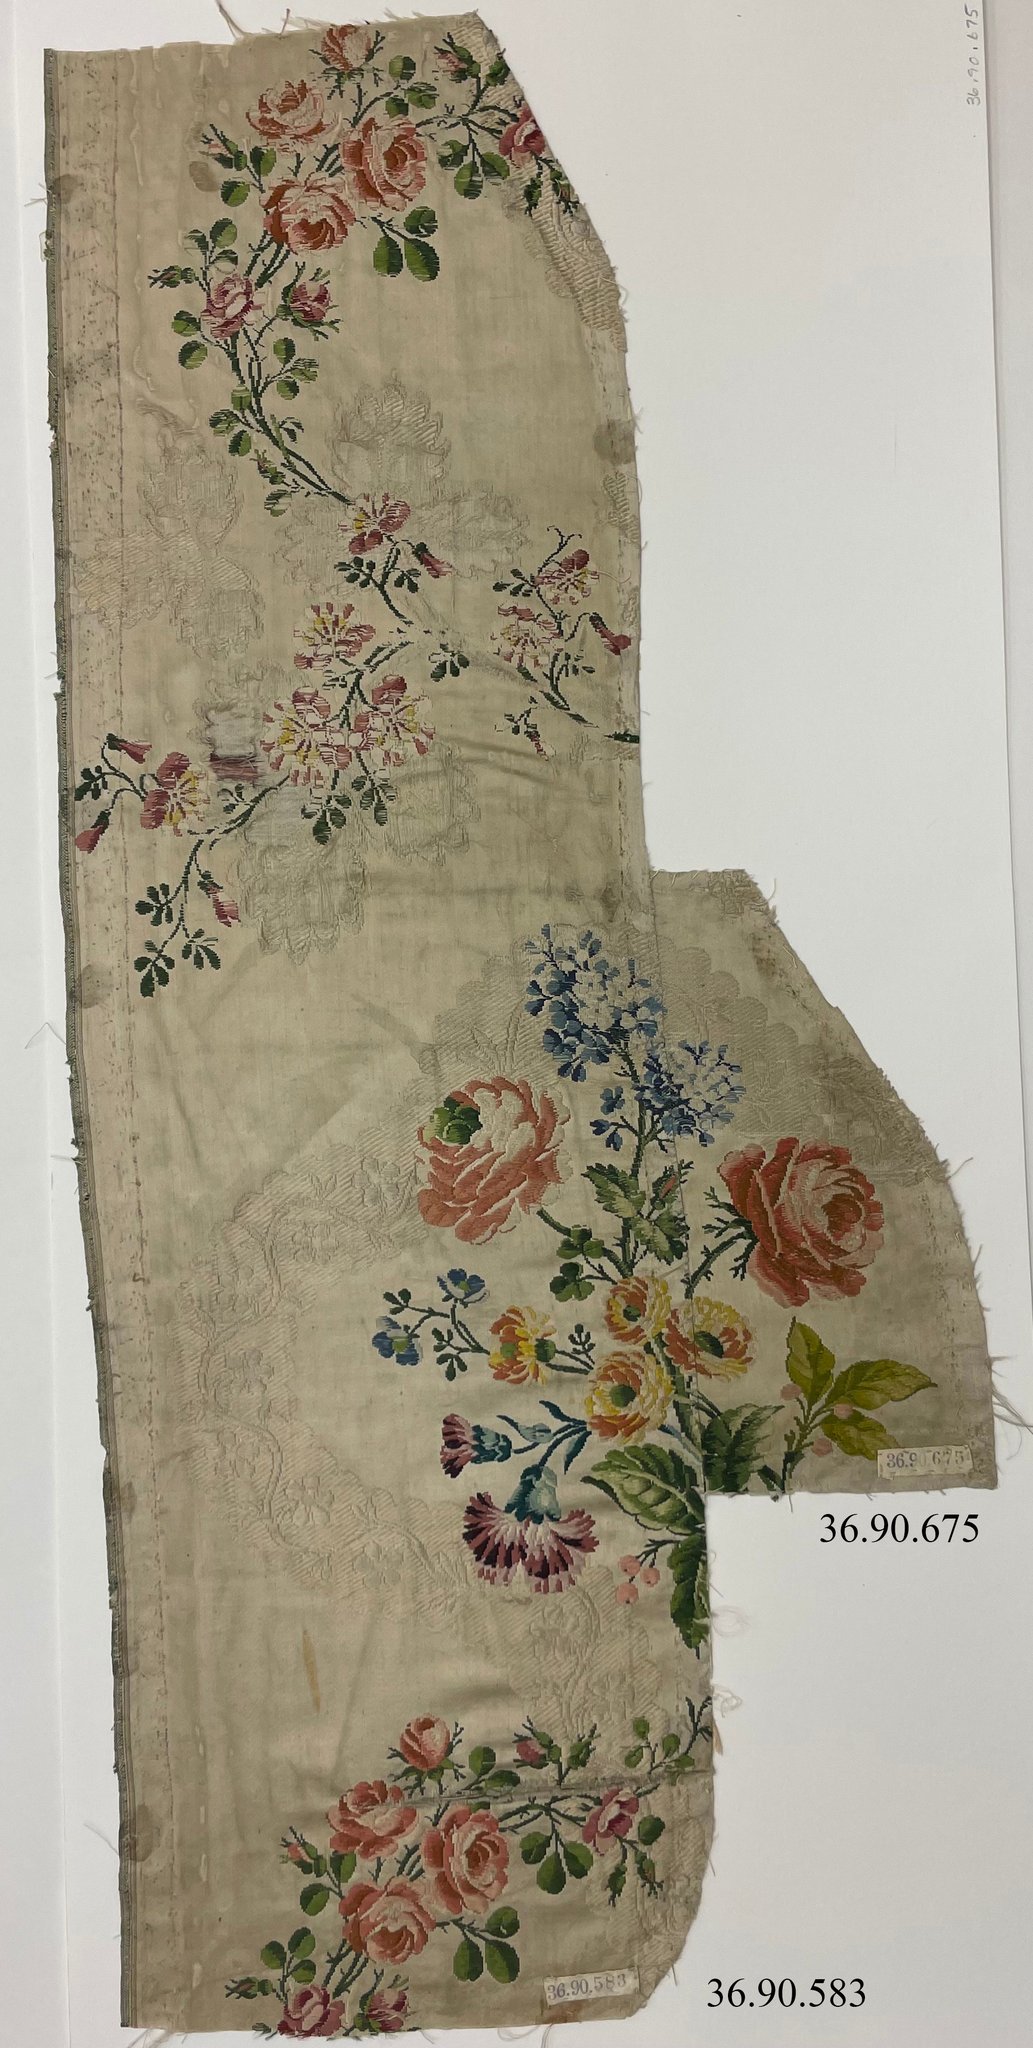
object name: piece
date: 1734-1766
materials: silk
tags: flowers